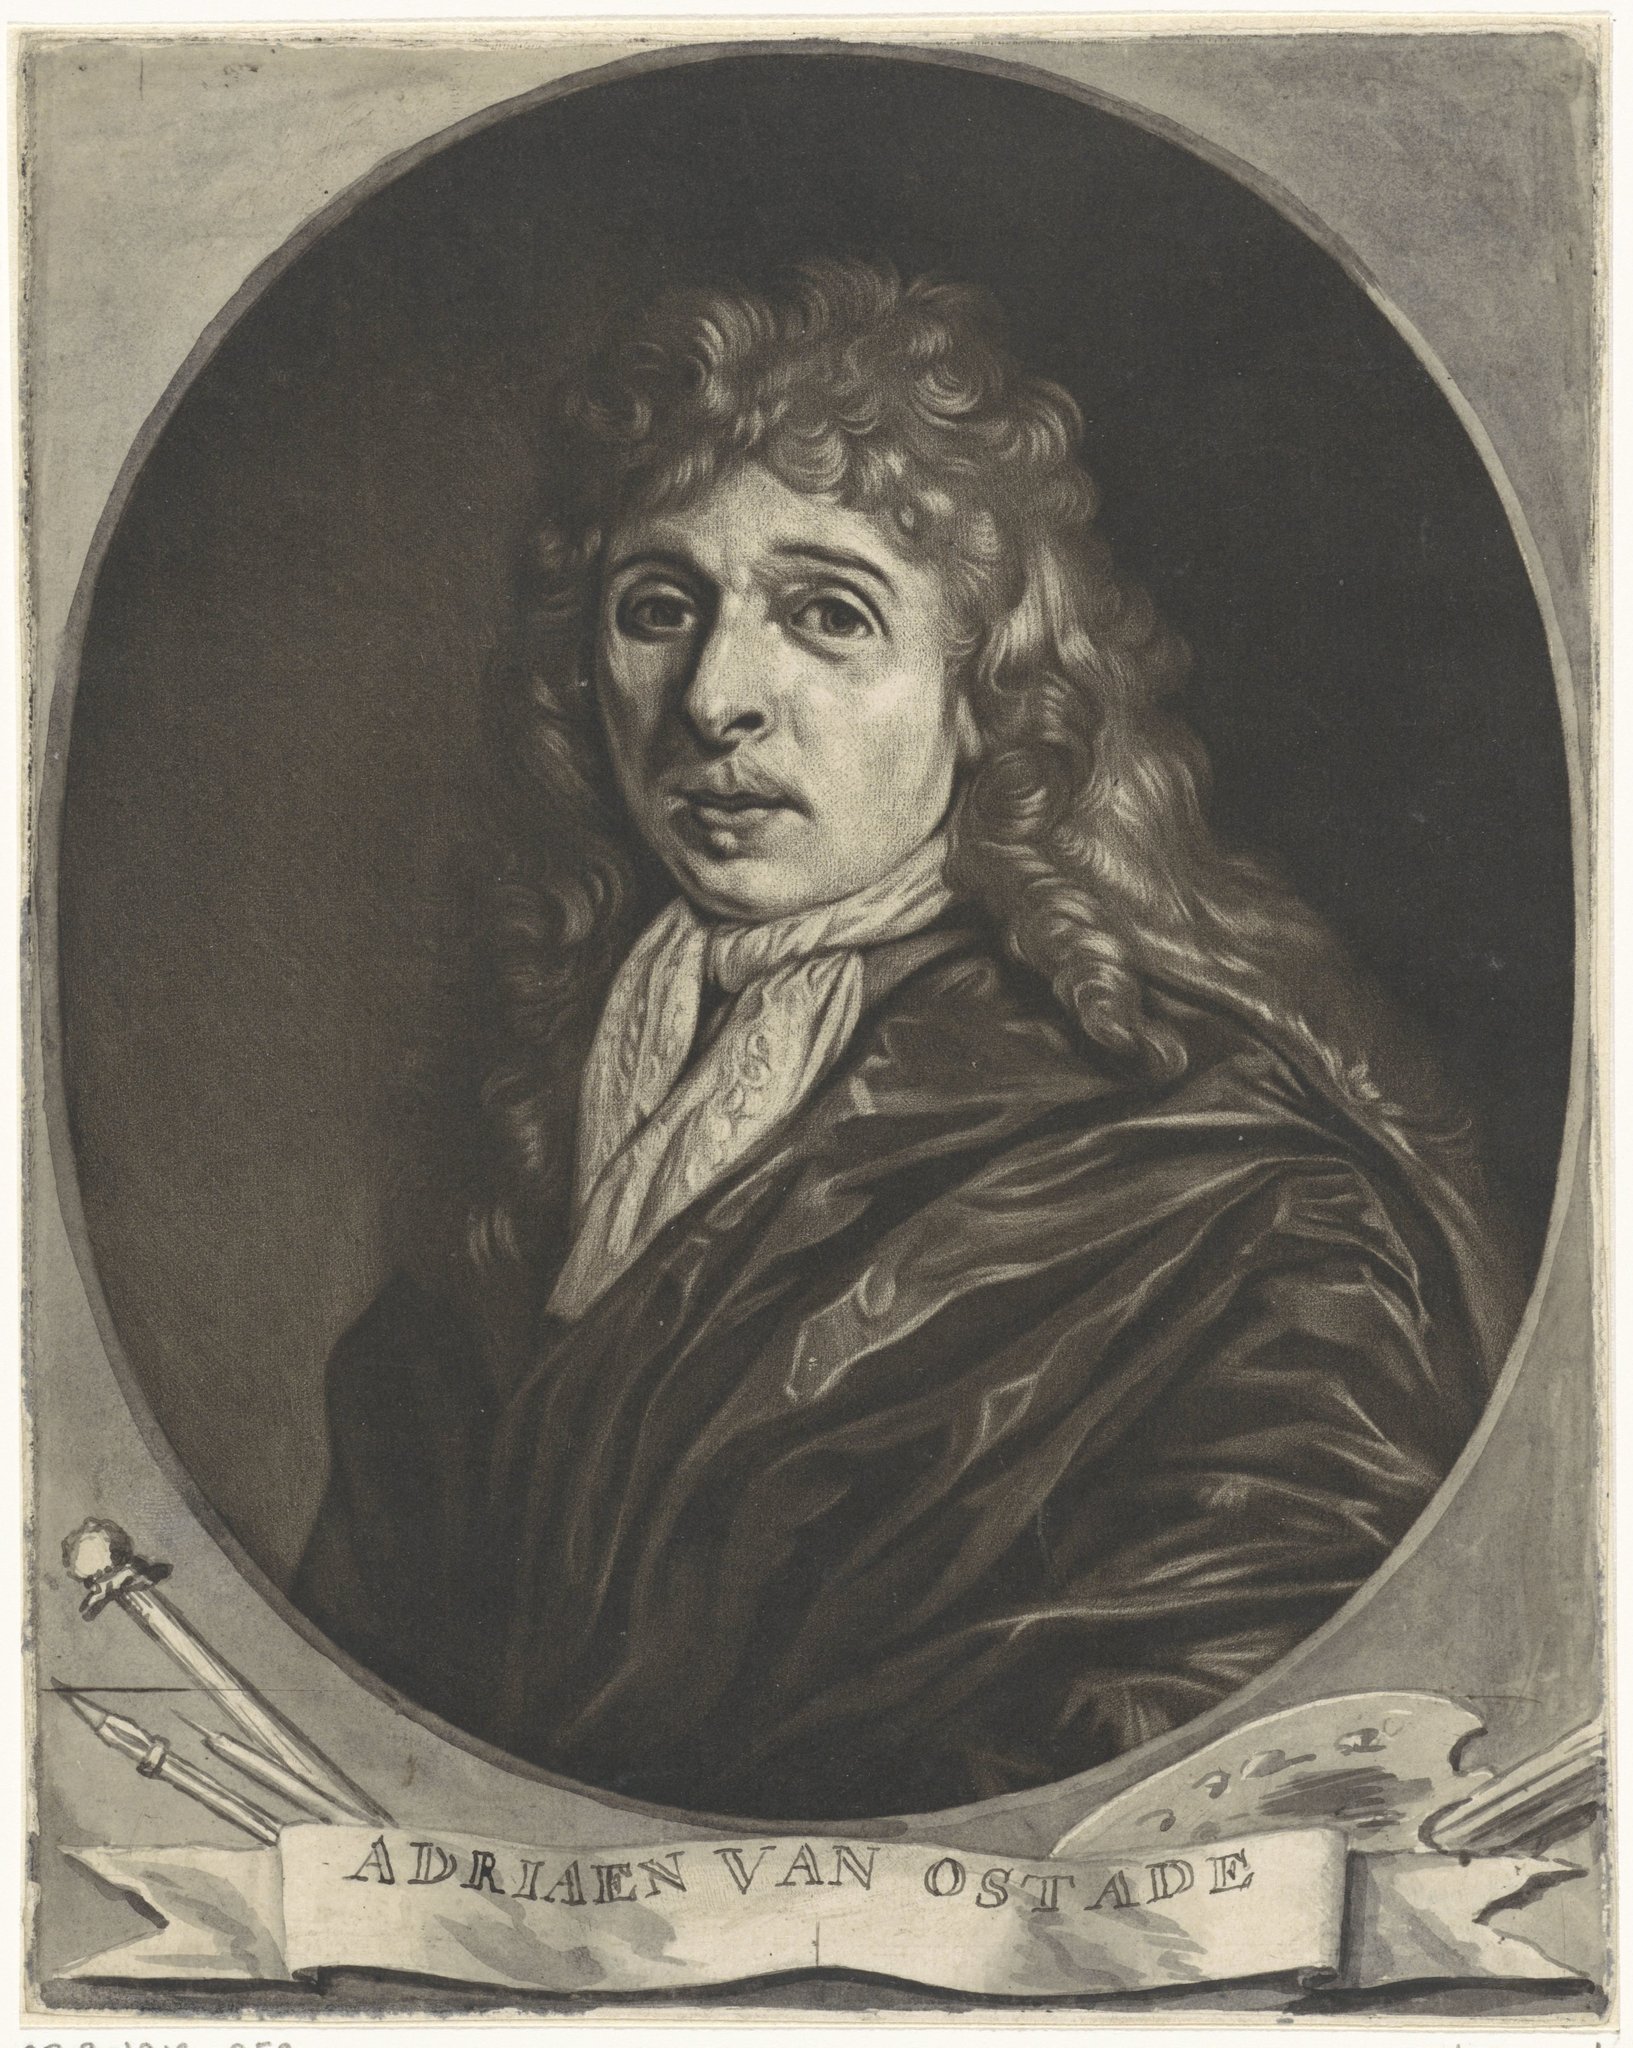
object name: print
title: Portret van Adriaen van Ostade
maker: jacob gole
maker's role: print maker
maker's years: 1660-1724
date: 1685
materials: paper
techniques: brush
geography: amsterdam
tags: painter, print maker, draughtsman, adriaen van ostade, tools, implements of painter, palette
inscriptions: collector's mark: Lugt 2228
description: De schilder Adriaen van Ostade. Hij draagt een kraag van kant. Onder het portret schildersattributen.